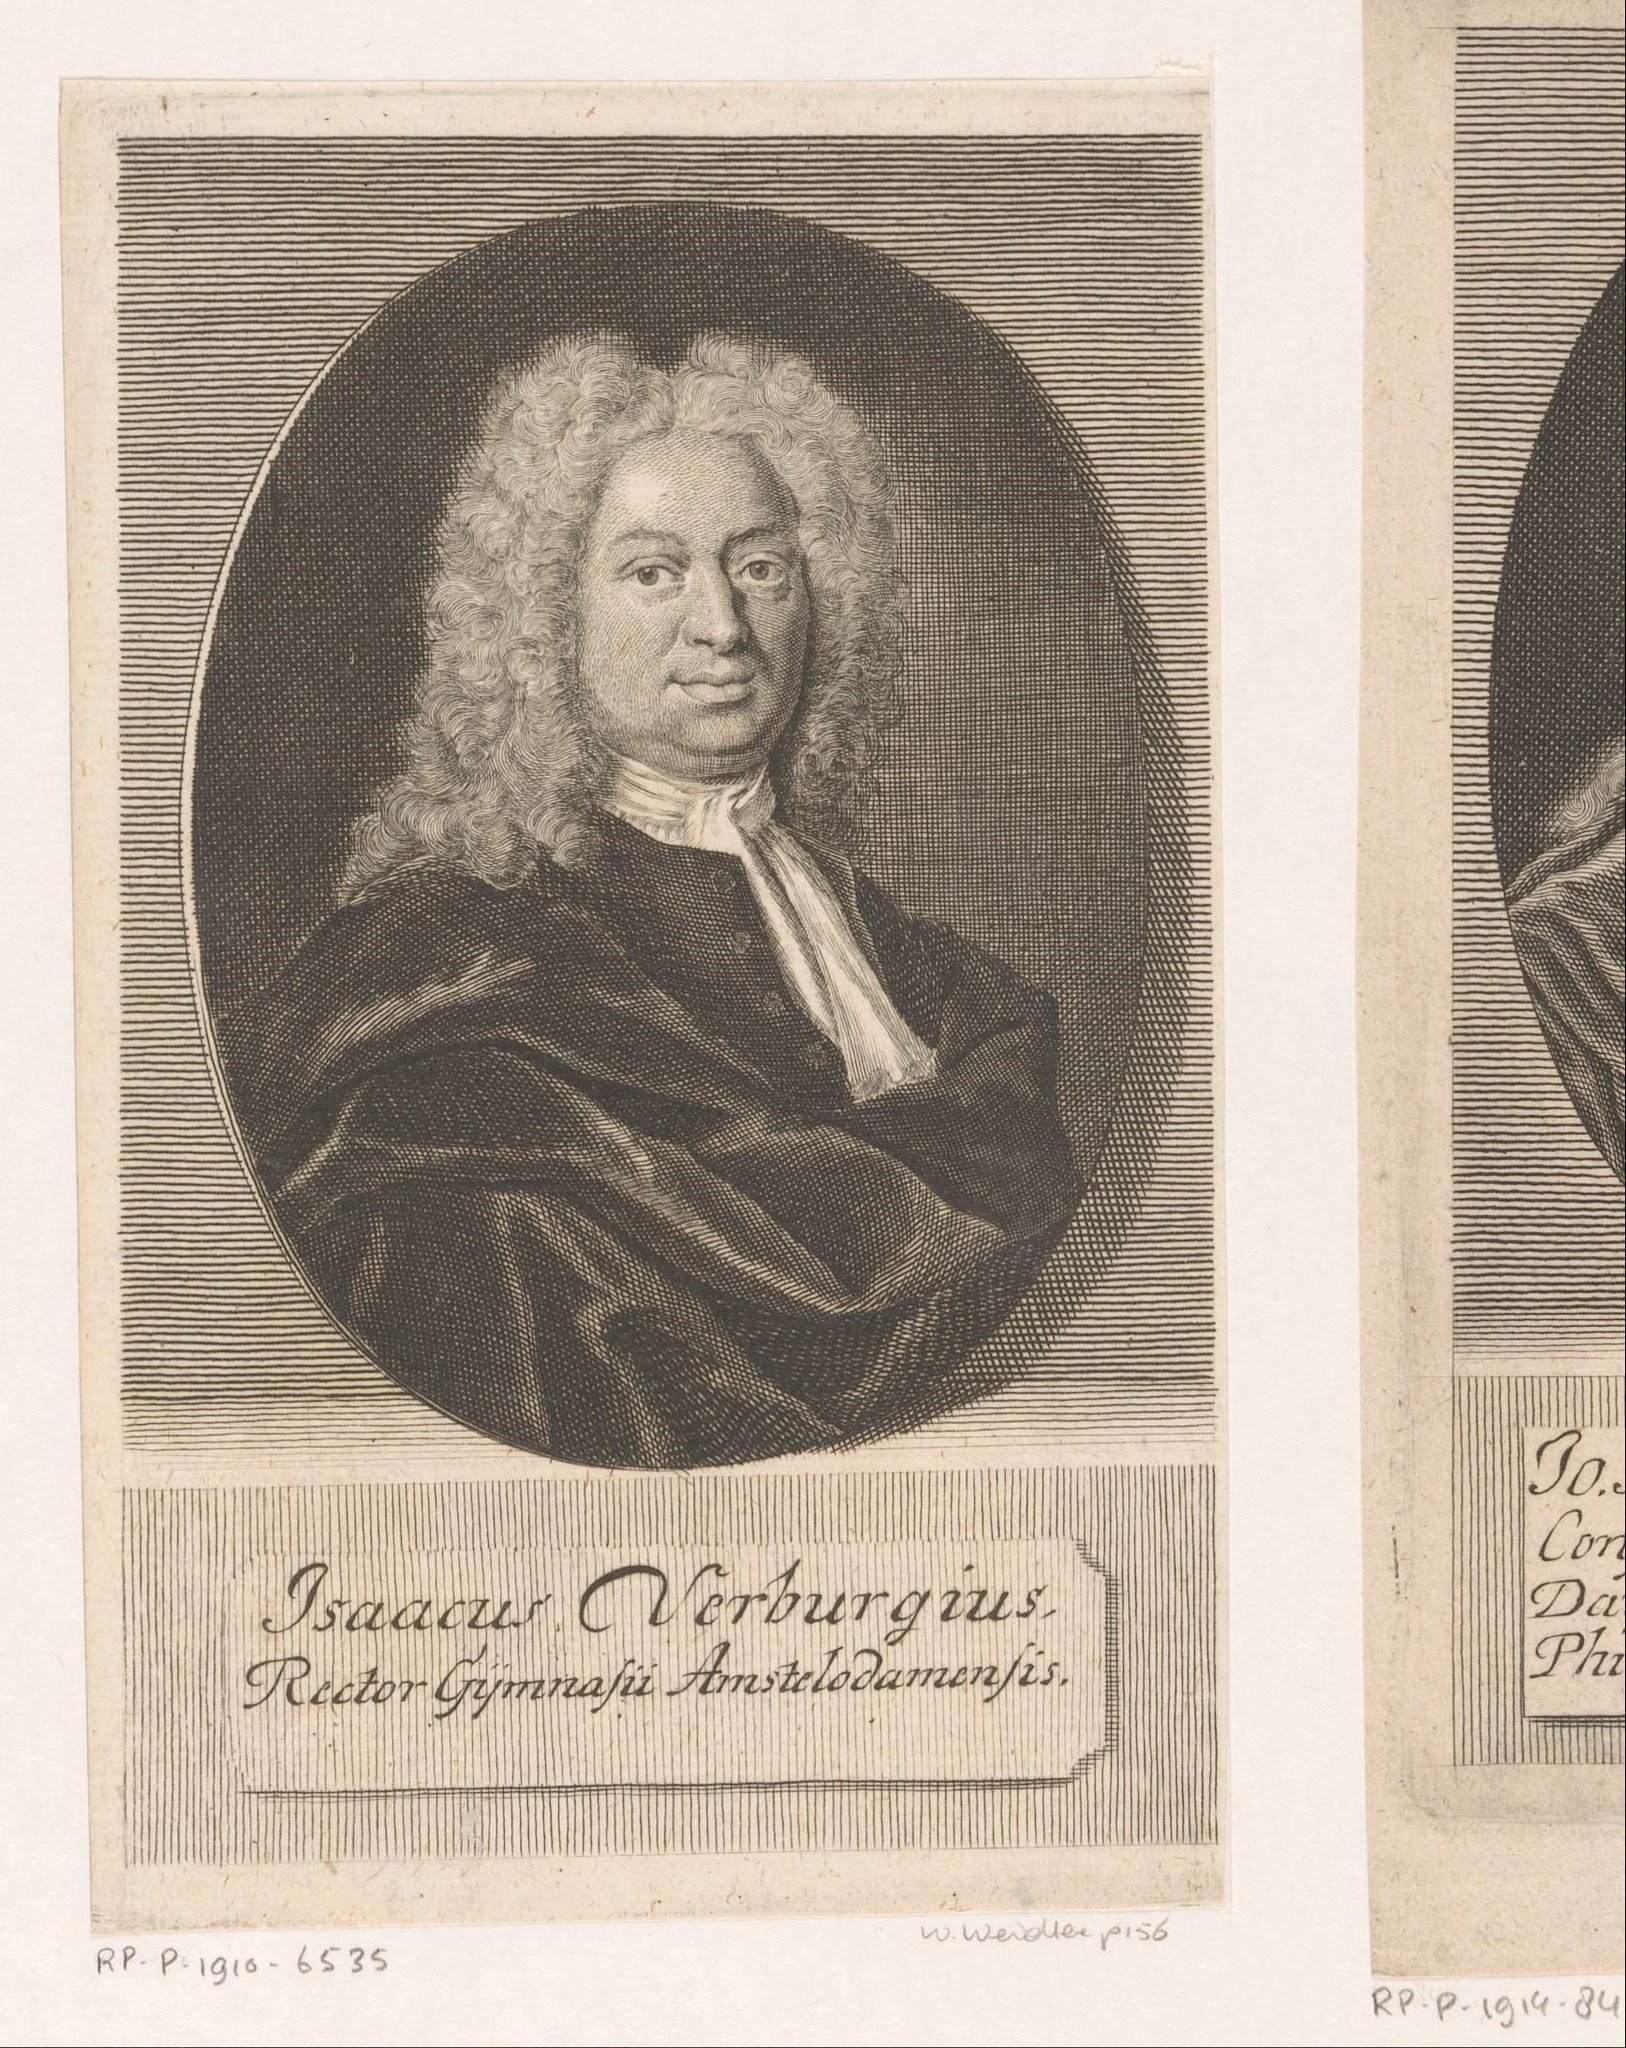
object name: print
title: Portret van Isaac Verburg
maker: martin bernigeroth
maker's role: print maker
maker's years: 1670-1733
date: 1727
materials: paper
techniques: engraving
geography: leipzig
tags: leiden, amsterdam, isaac verburg, historical persons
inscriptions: collector's mark: Lugt 2228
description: Prent ook gebruikt in: Deutsche Acta Eruditorum (...). dl. 129. Leipzig: Johann Gottlieb Gleditsch, 1727.